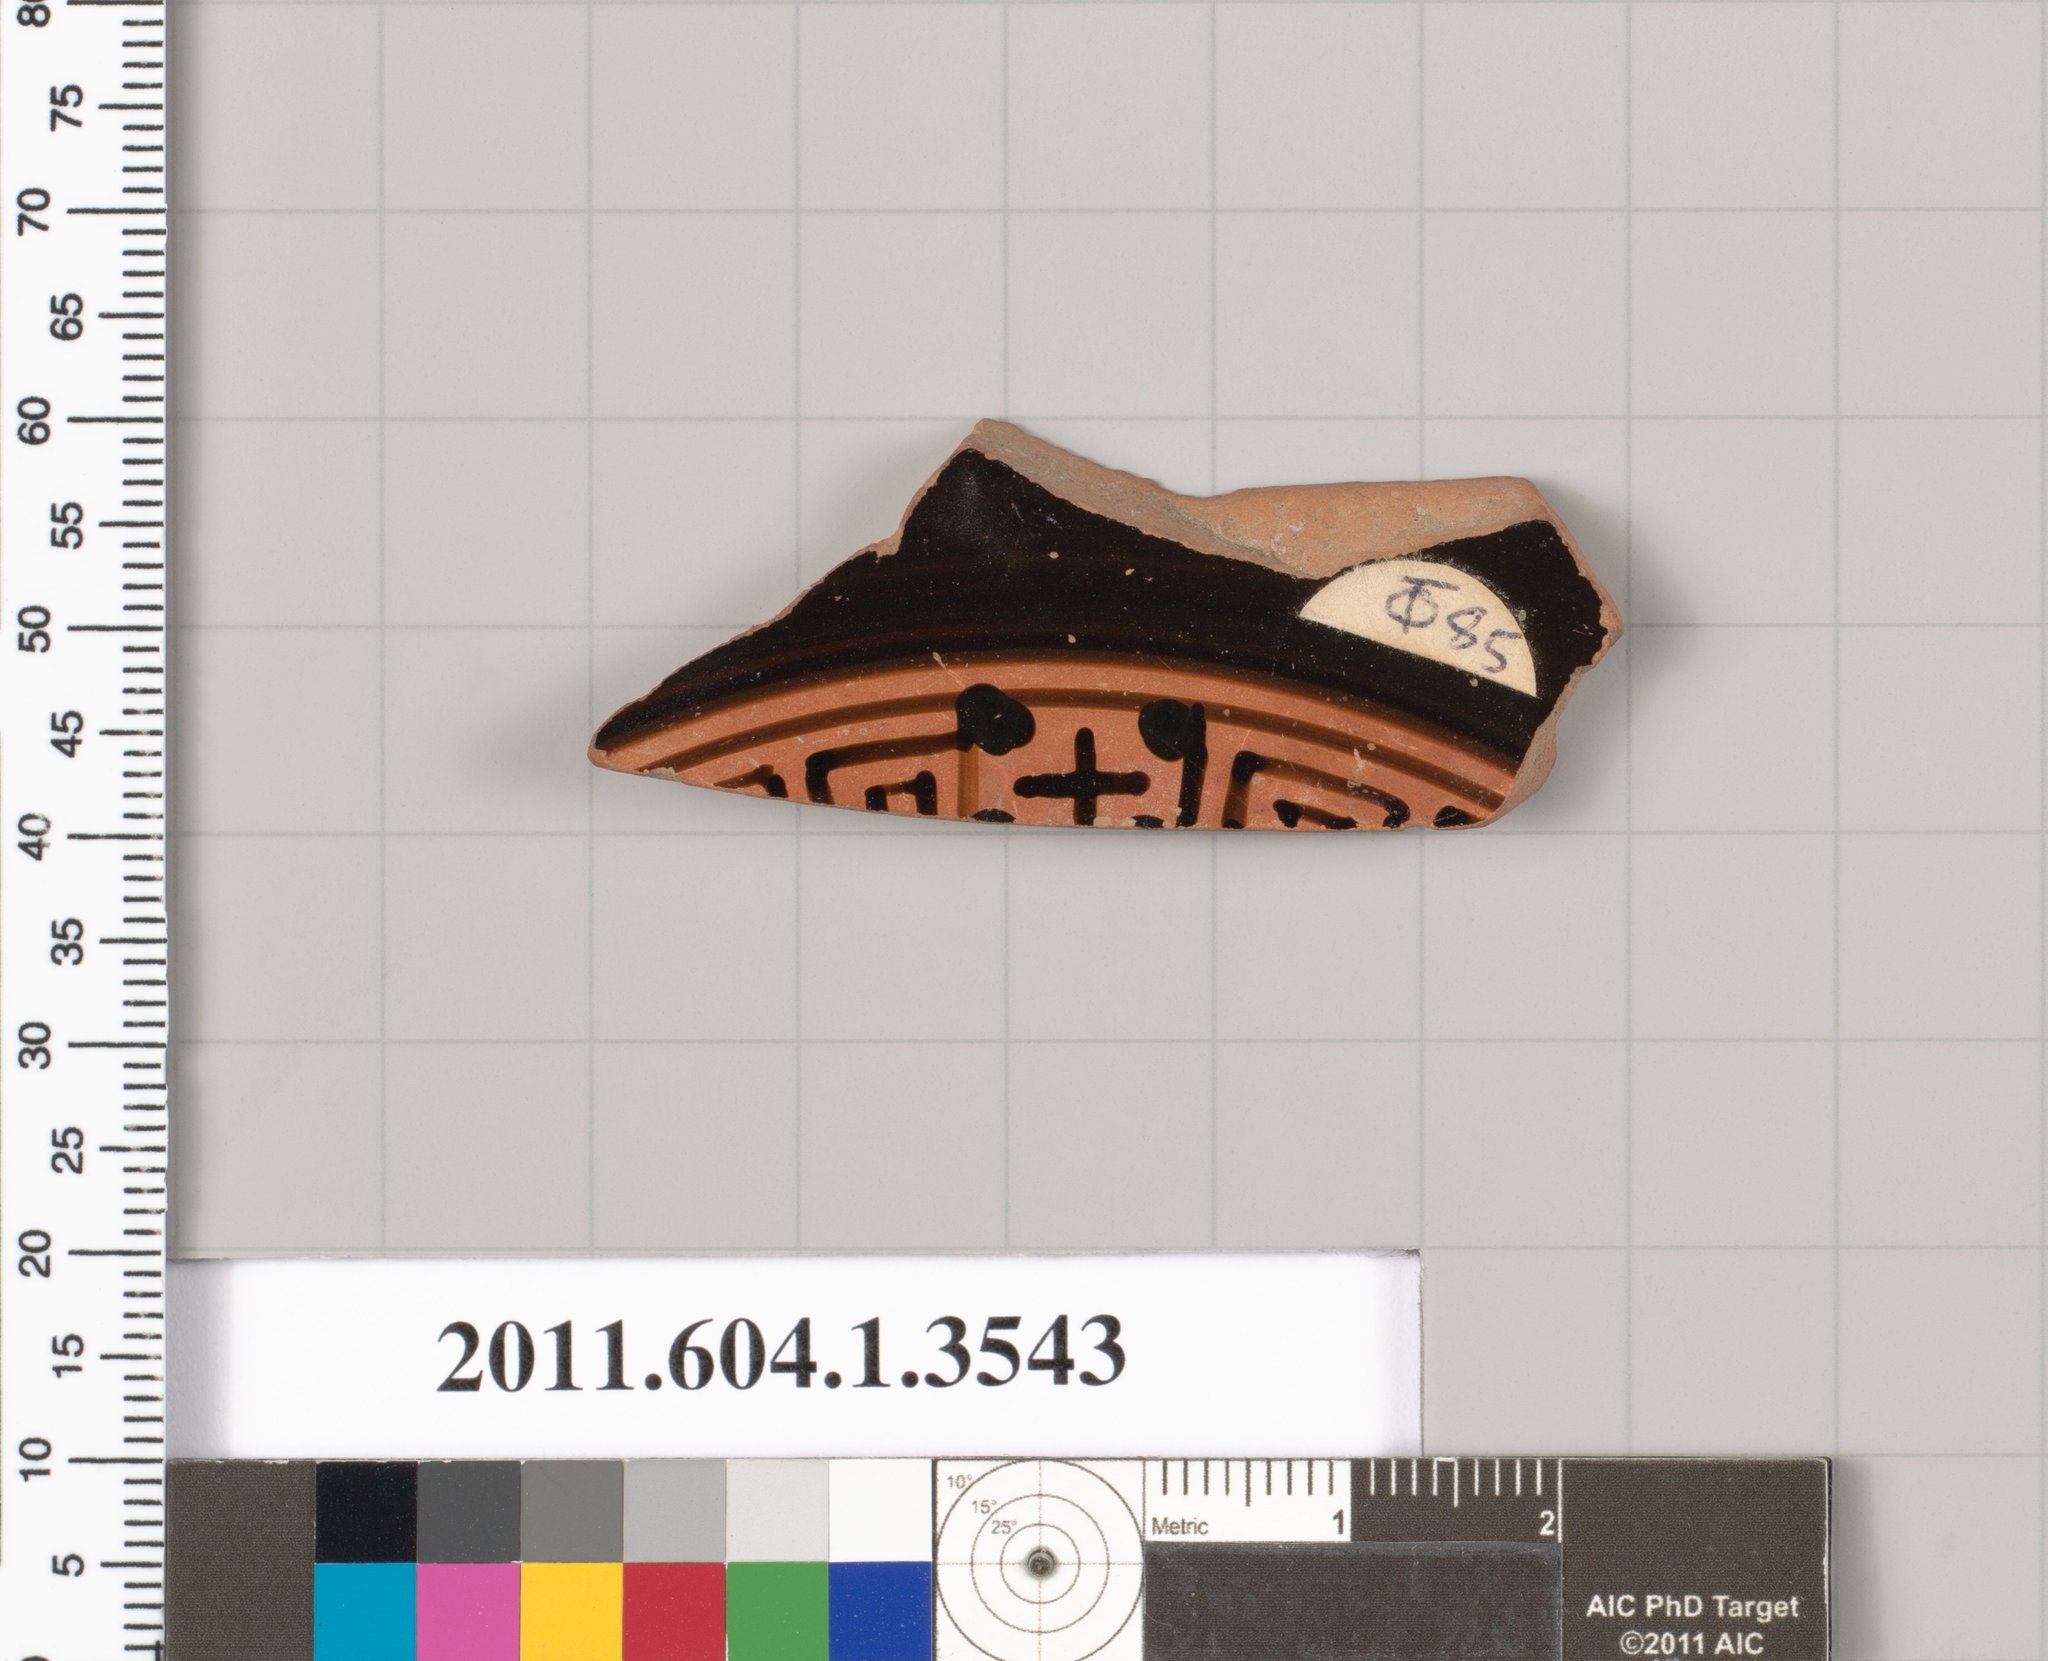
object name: kylix fragment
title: Terracotta fragment of a kylix (drinking cup)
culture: greek, attic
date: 490-470 BCE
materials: terracotta